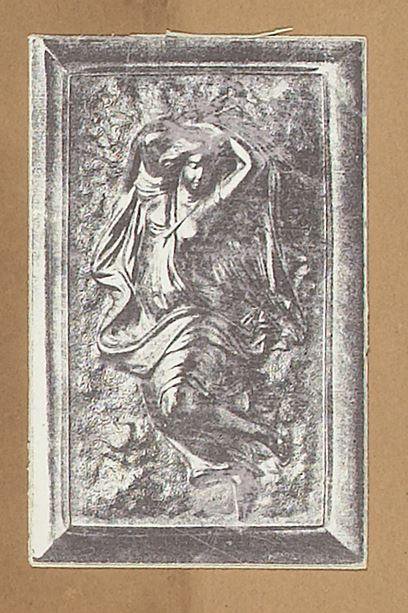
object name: photograph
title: Reproductie van reliëf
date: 1869-1875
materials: cardboard, paper, photographic support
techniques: photograph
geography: amsterdam